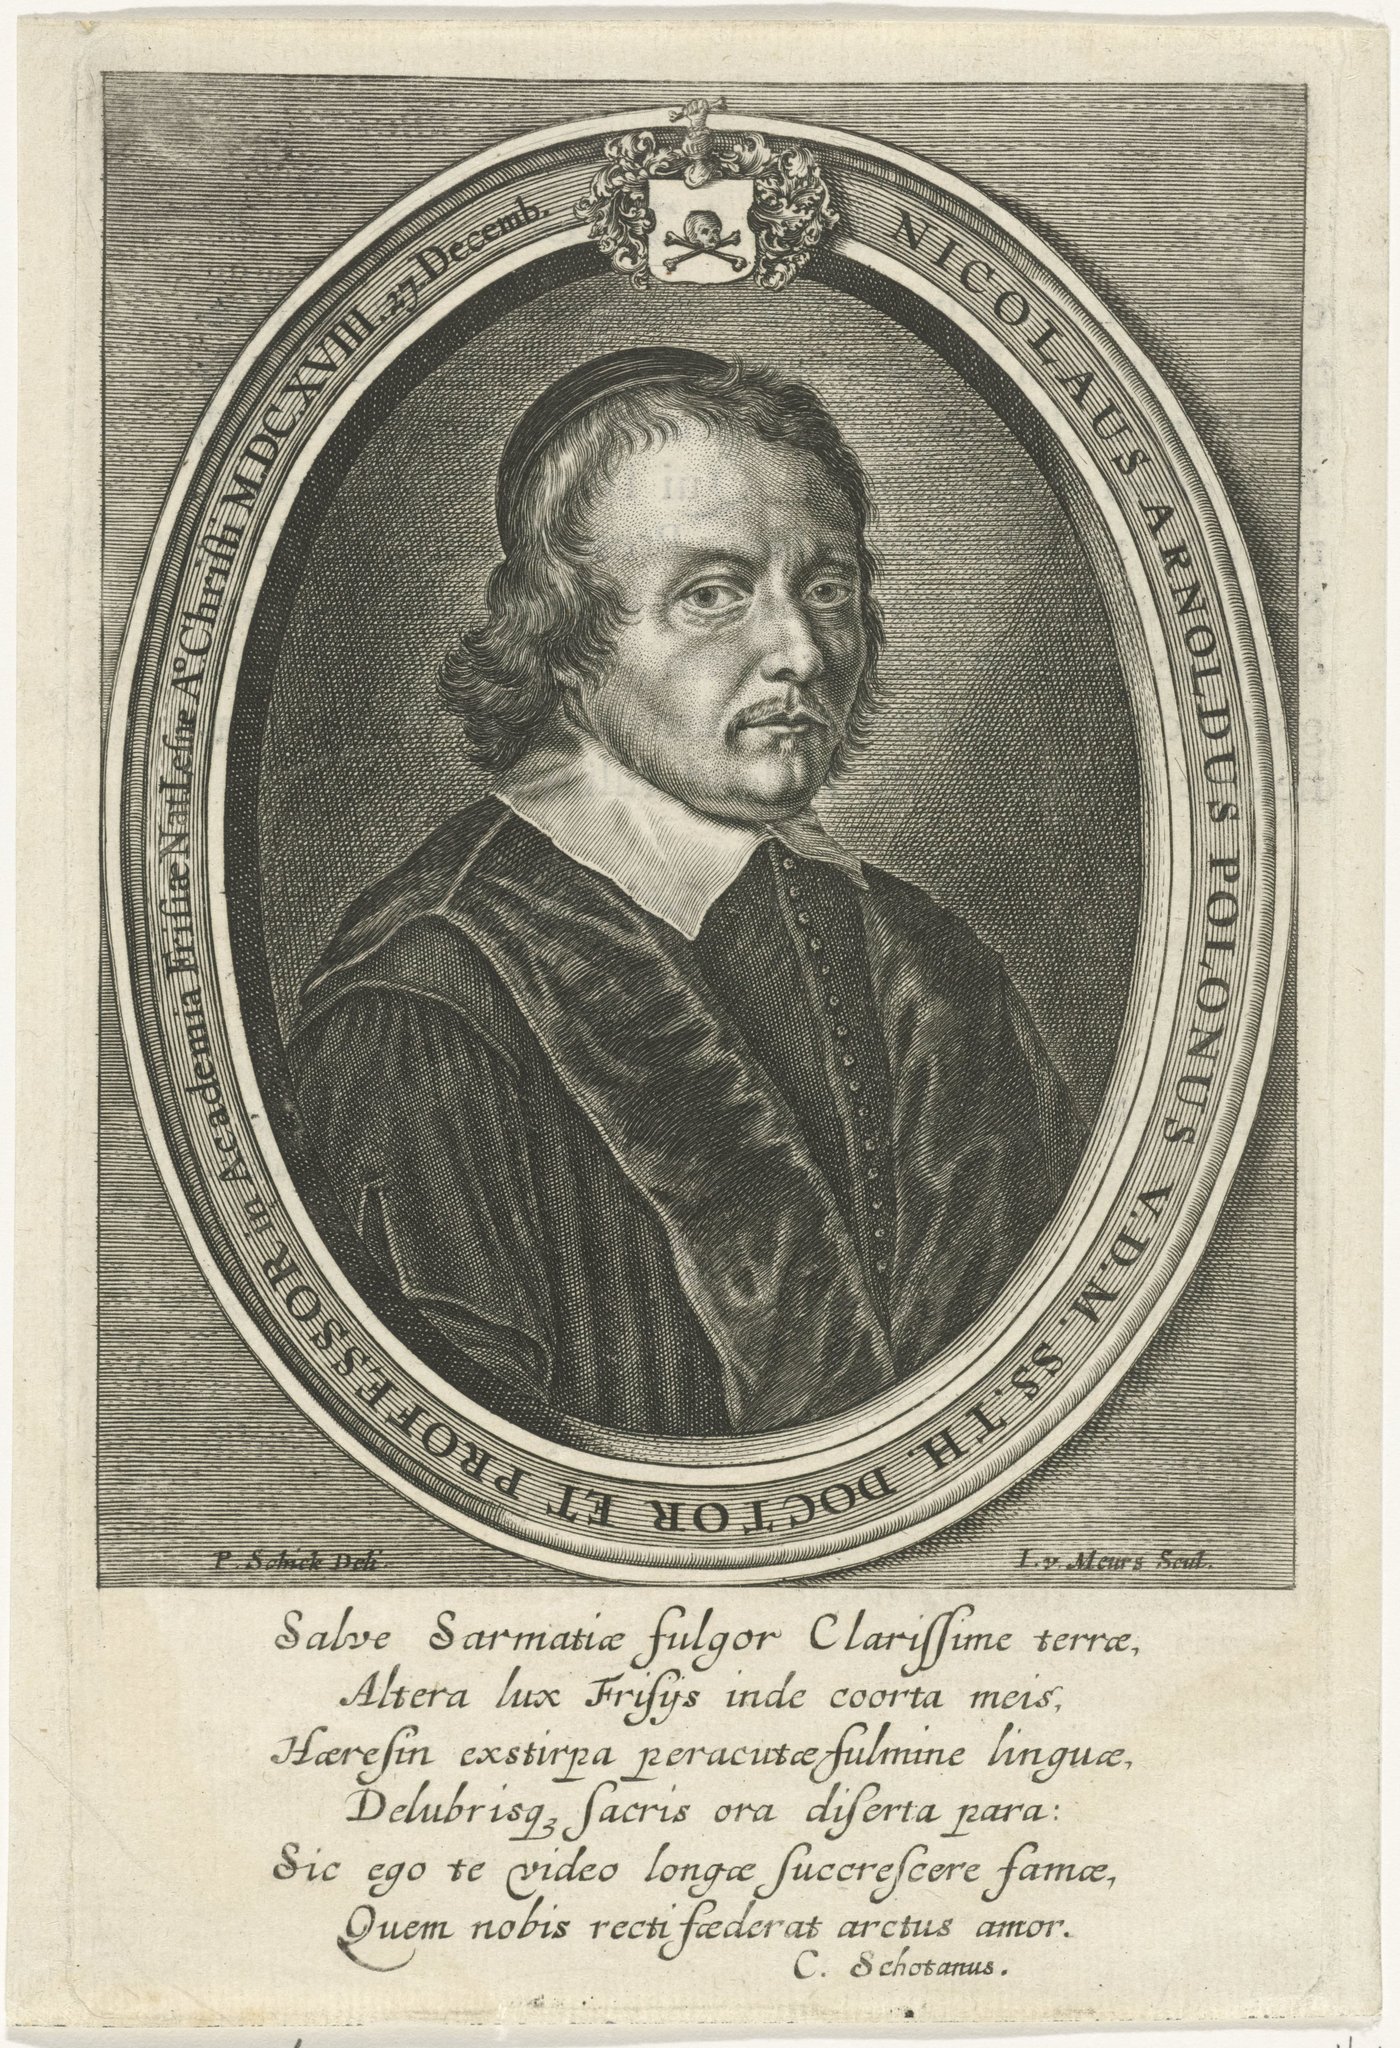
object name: book illustration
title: Portret van Nicolaus Arnoldus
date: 1654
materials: paper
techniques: engraving, letterpress printing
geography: amsterdam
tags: franeker, nicolaus arnoldi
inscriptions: collector's mark: Lugt 2228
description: Prent uit: Arnoldi, Nicolaas. Religio sociniana sev Catechesis Racoviana maior publicis disputationibus (...) refutata. Amsterdam en Franeker: Johannes Janssonius en Idzard Albertsz, 1654.